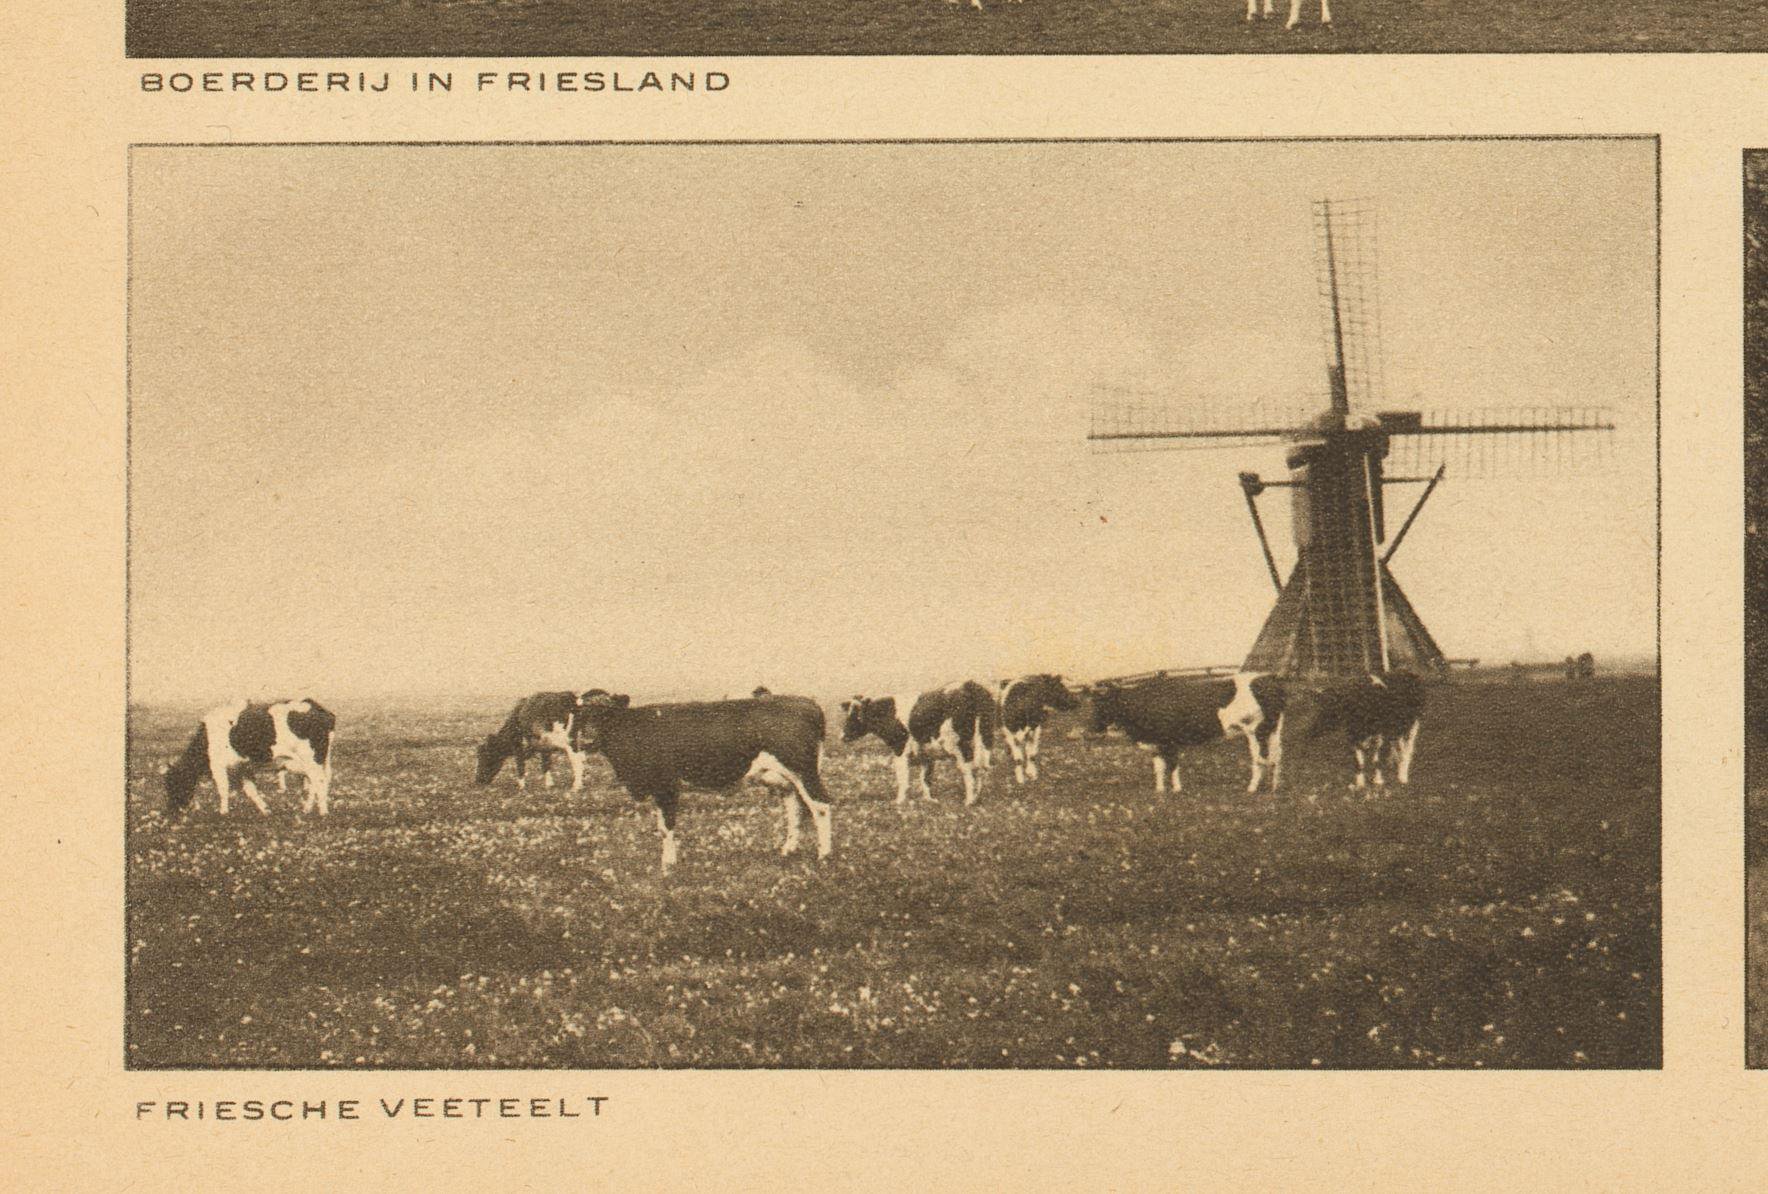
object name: album leaf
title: Koeien in een weiland met molen in Friesland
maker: Anonymous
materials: paper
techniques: rotogravure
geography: friesland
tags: cow, windmill in landscape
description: Deze prent maakt deel uit van een album.